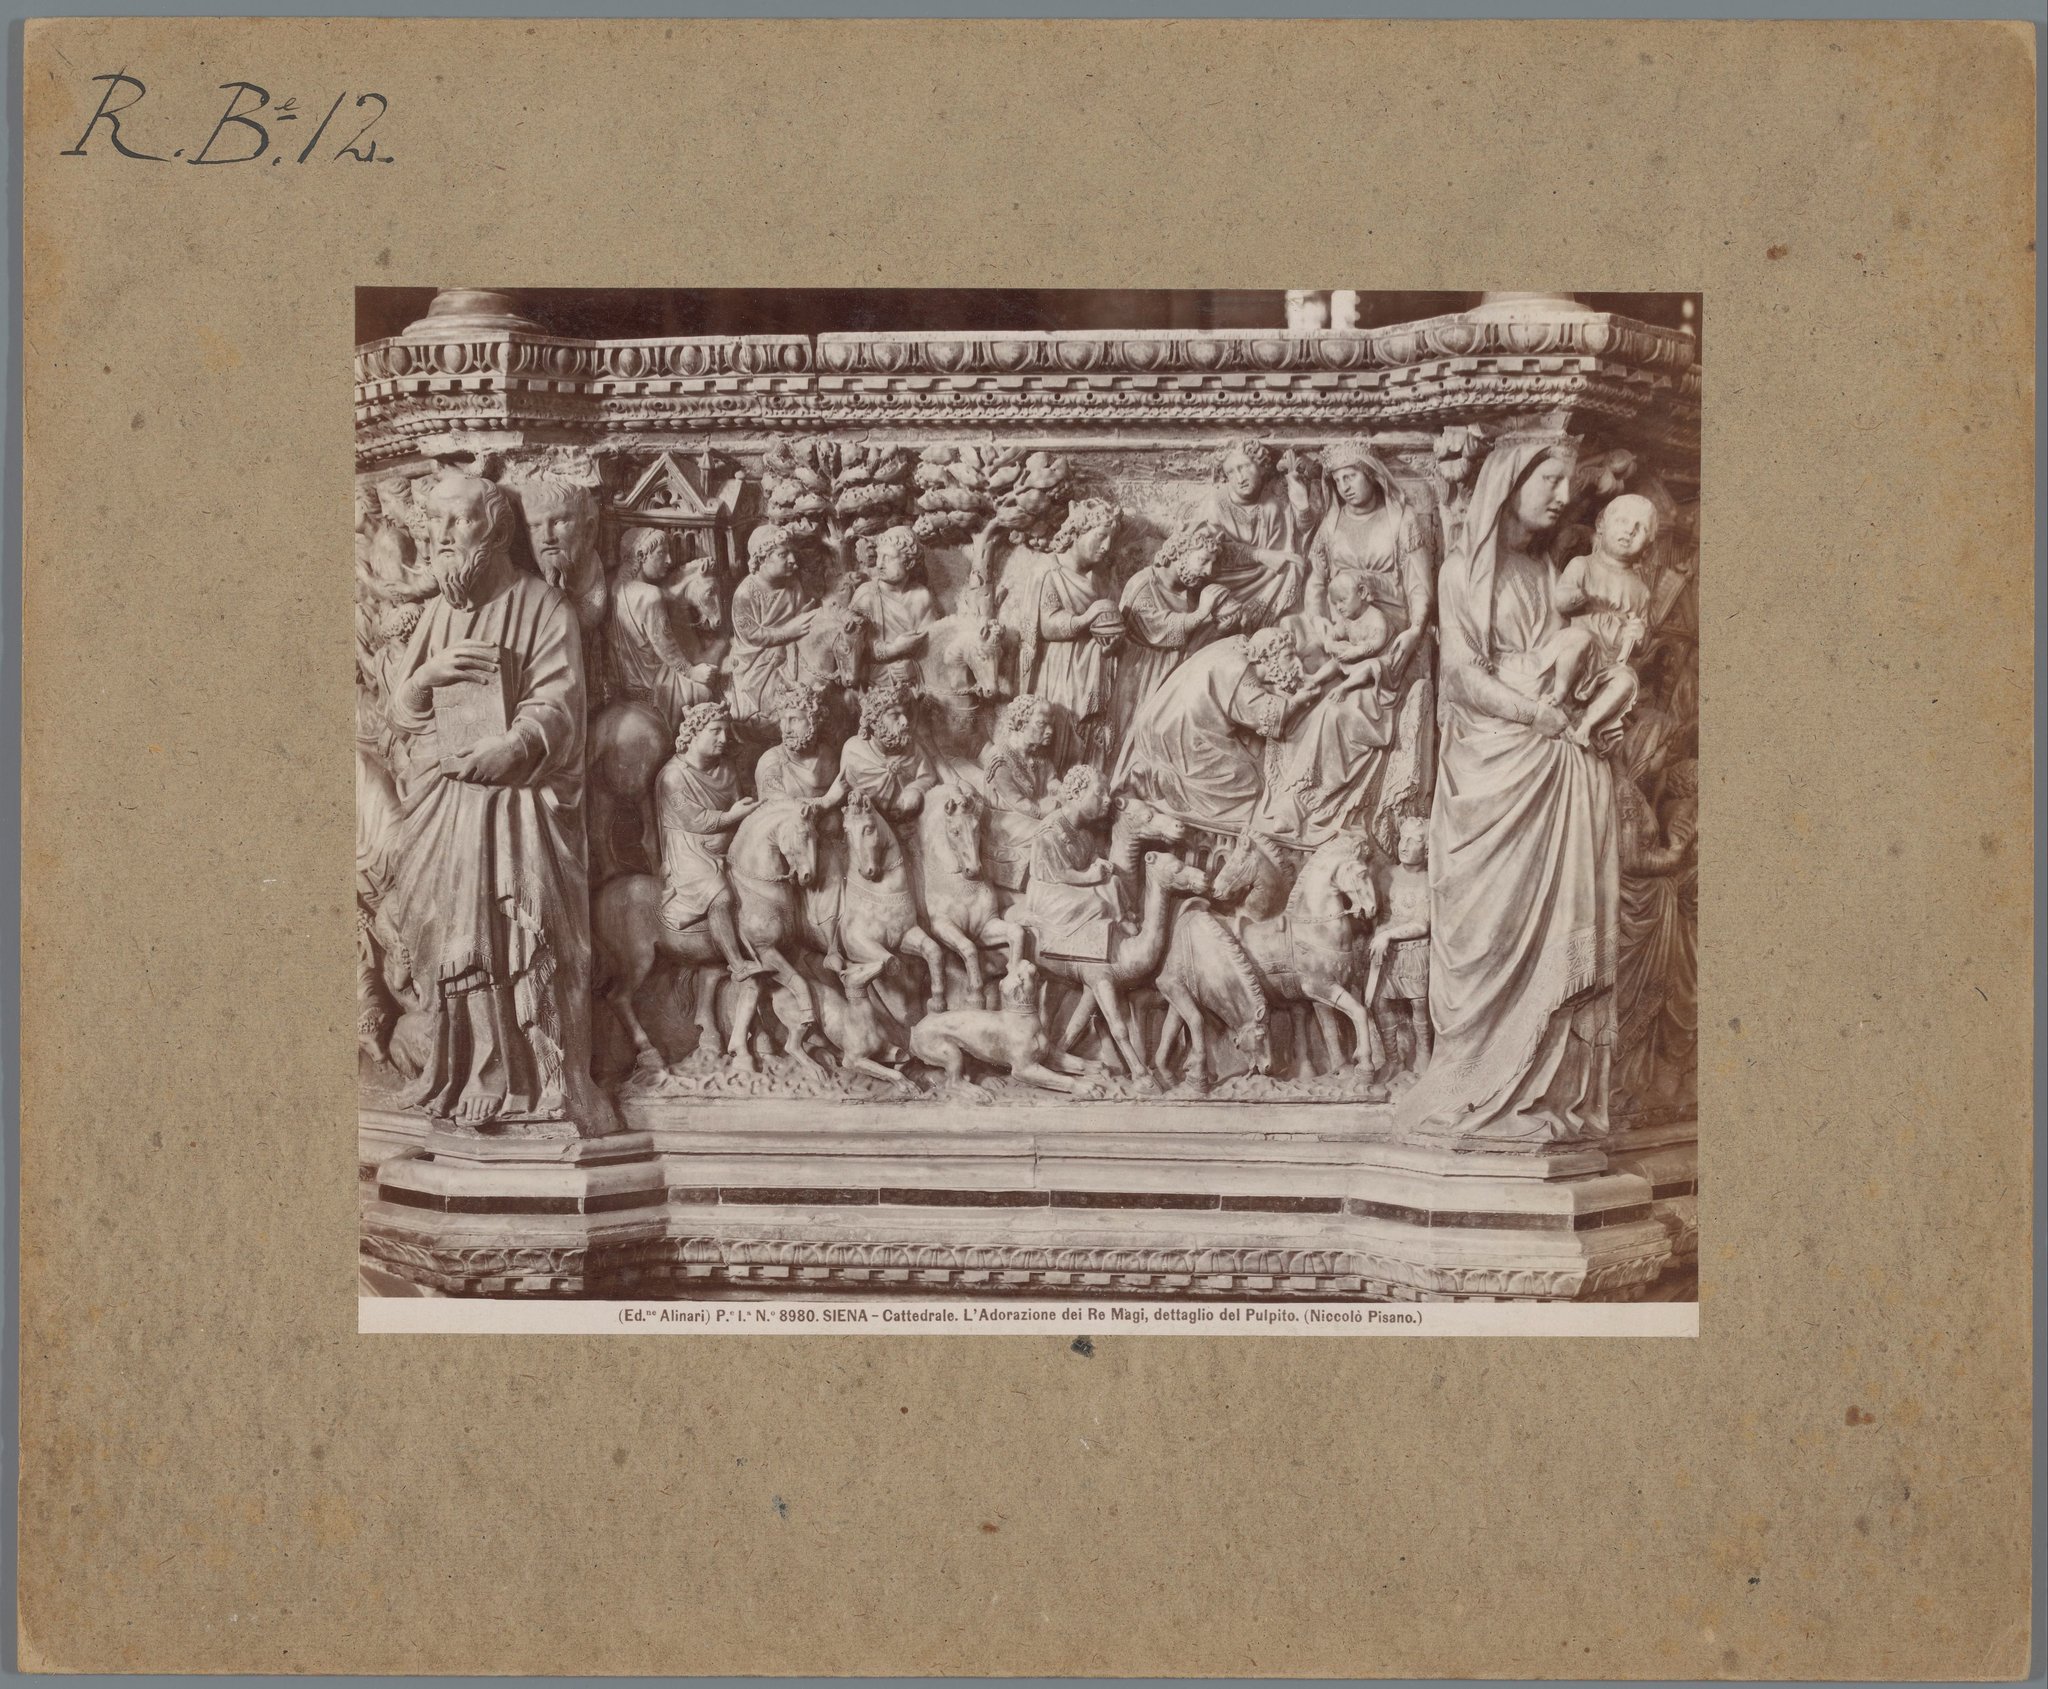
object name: photograph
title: SIENA - Cattedrale. L'Adorazione dei Re Magi, dettaglio del Pulpito.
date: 1875-1900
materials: cardboard, photographic support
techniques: albumen print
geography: siena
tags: adoration of the kings: the wise men present their gifts to the christ-child (gold, frankincense and myrrh), interior of church, pulpit, ambo, chancel, sculpture (+ relief ~ sculpture)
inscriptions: collector's mark: Lugt 3937, number: ‘P.e 1.a N. 8980.’